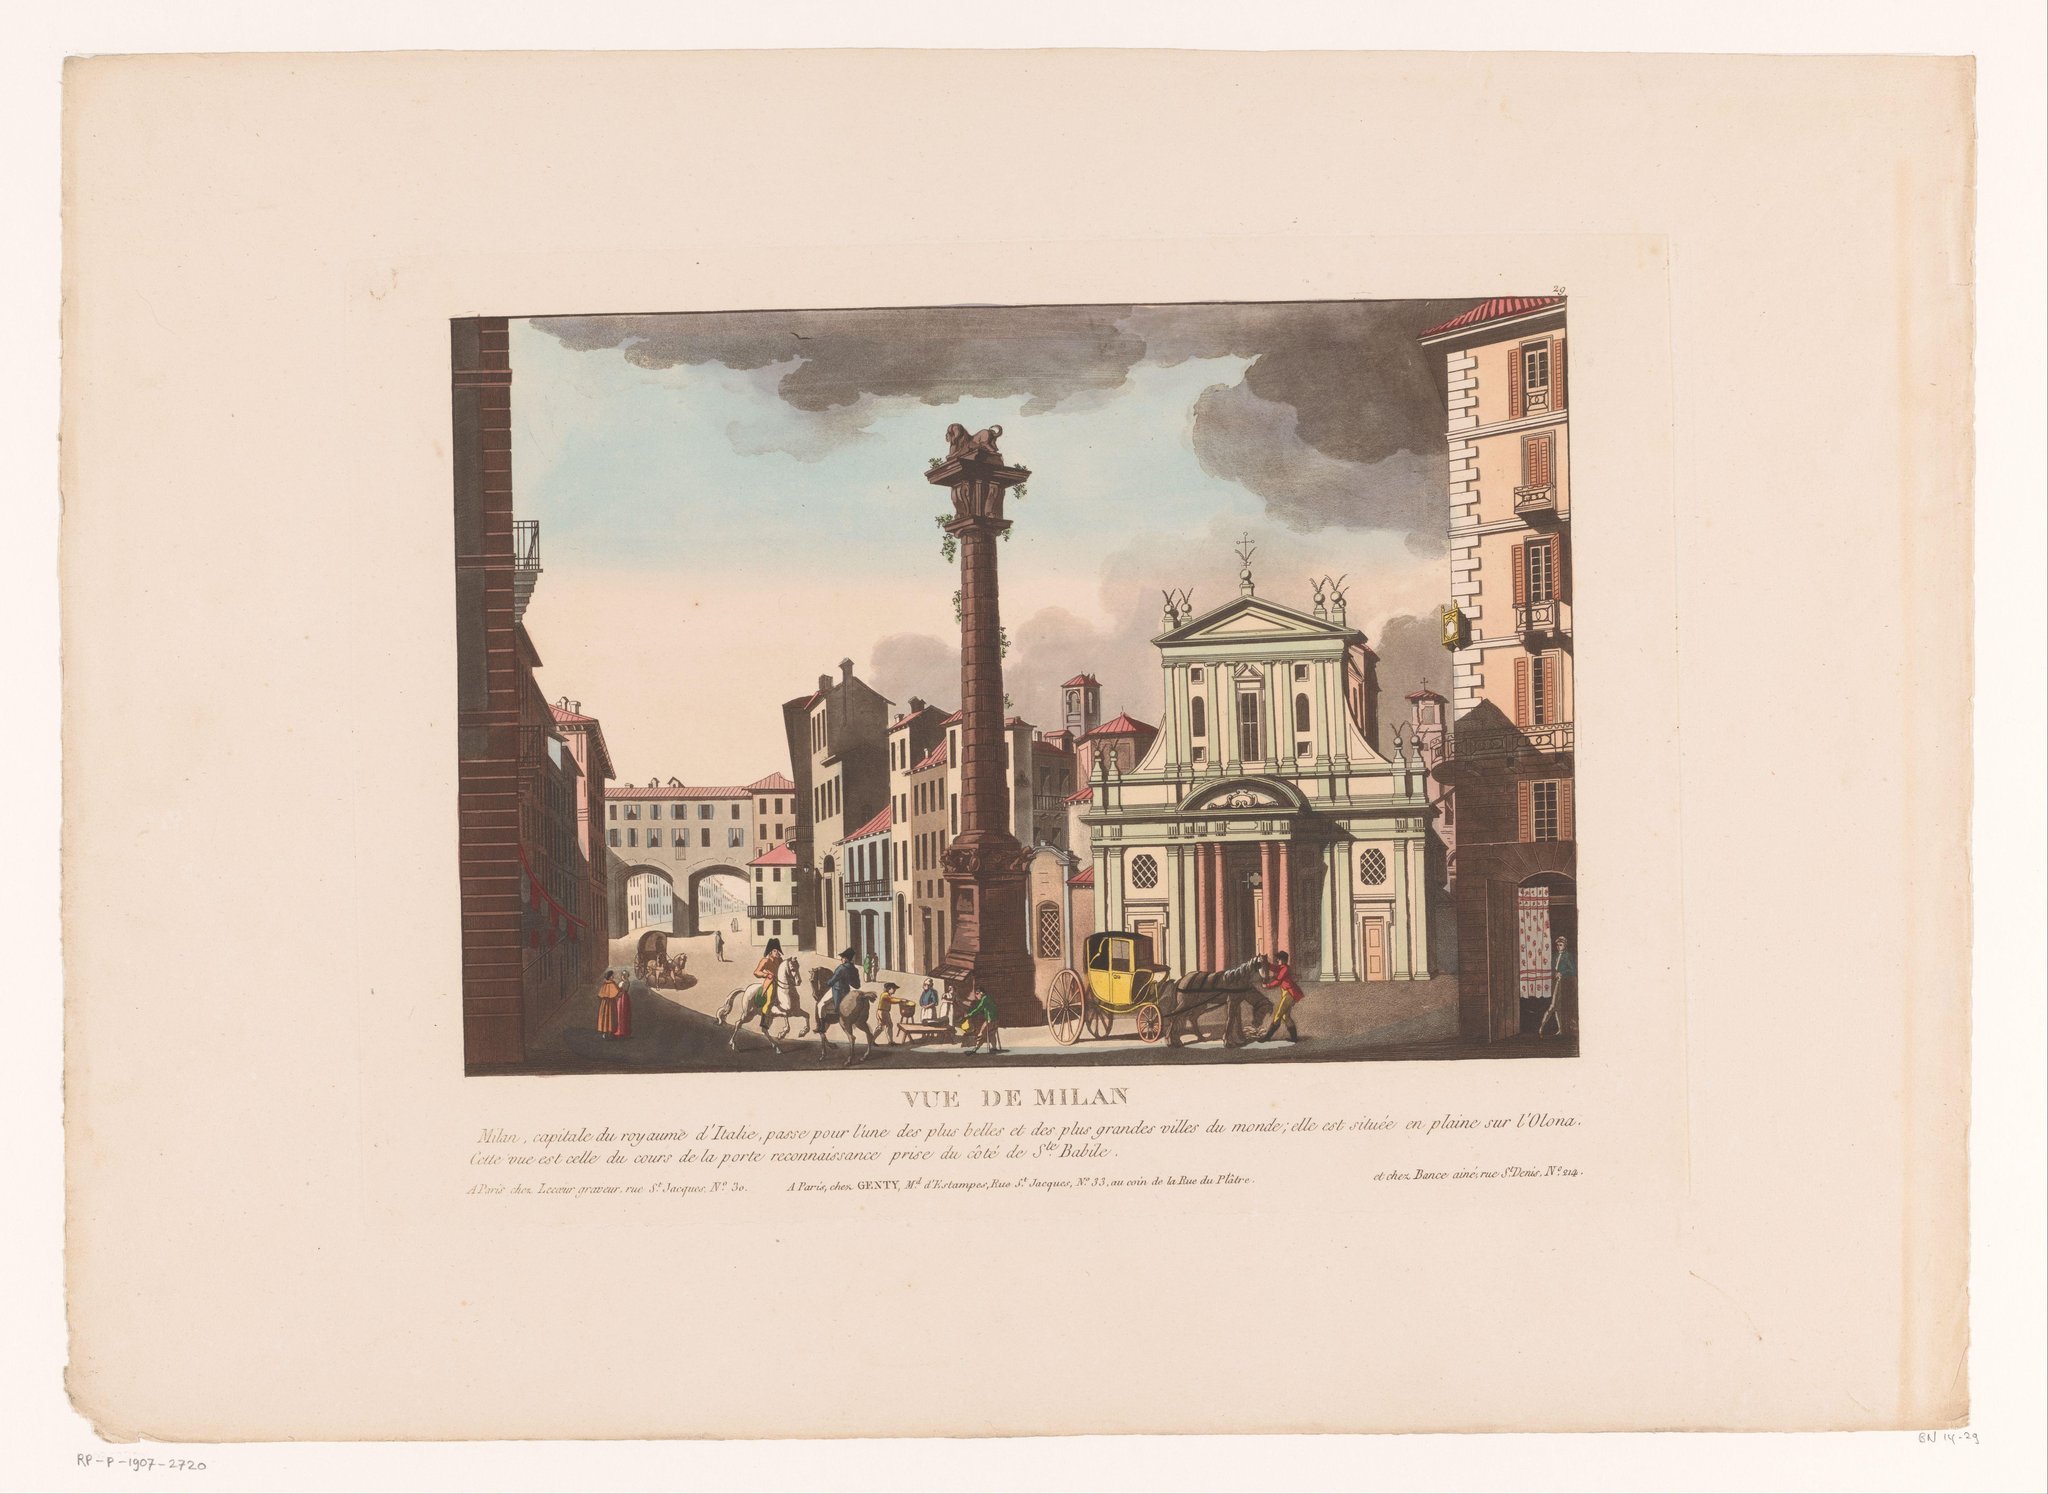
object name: print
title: Vue de Milan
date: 1812-1814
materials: paper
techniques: aquatint, etching, hand coloring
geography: paris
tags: square, place, circus, etc., city-view in general; 'veduta', church (exterior)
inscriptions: collector's mark: Lugt 2228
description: Maakt mogelijk deel uit van een serie met stadsgezichten in Italië, Spanje en Egypte.